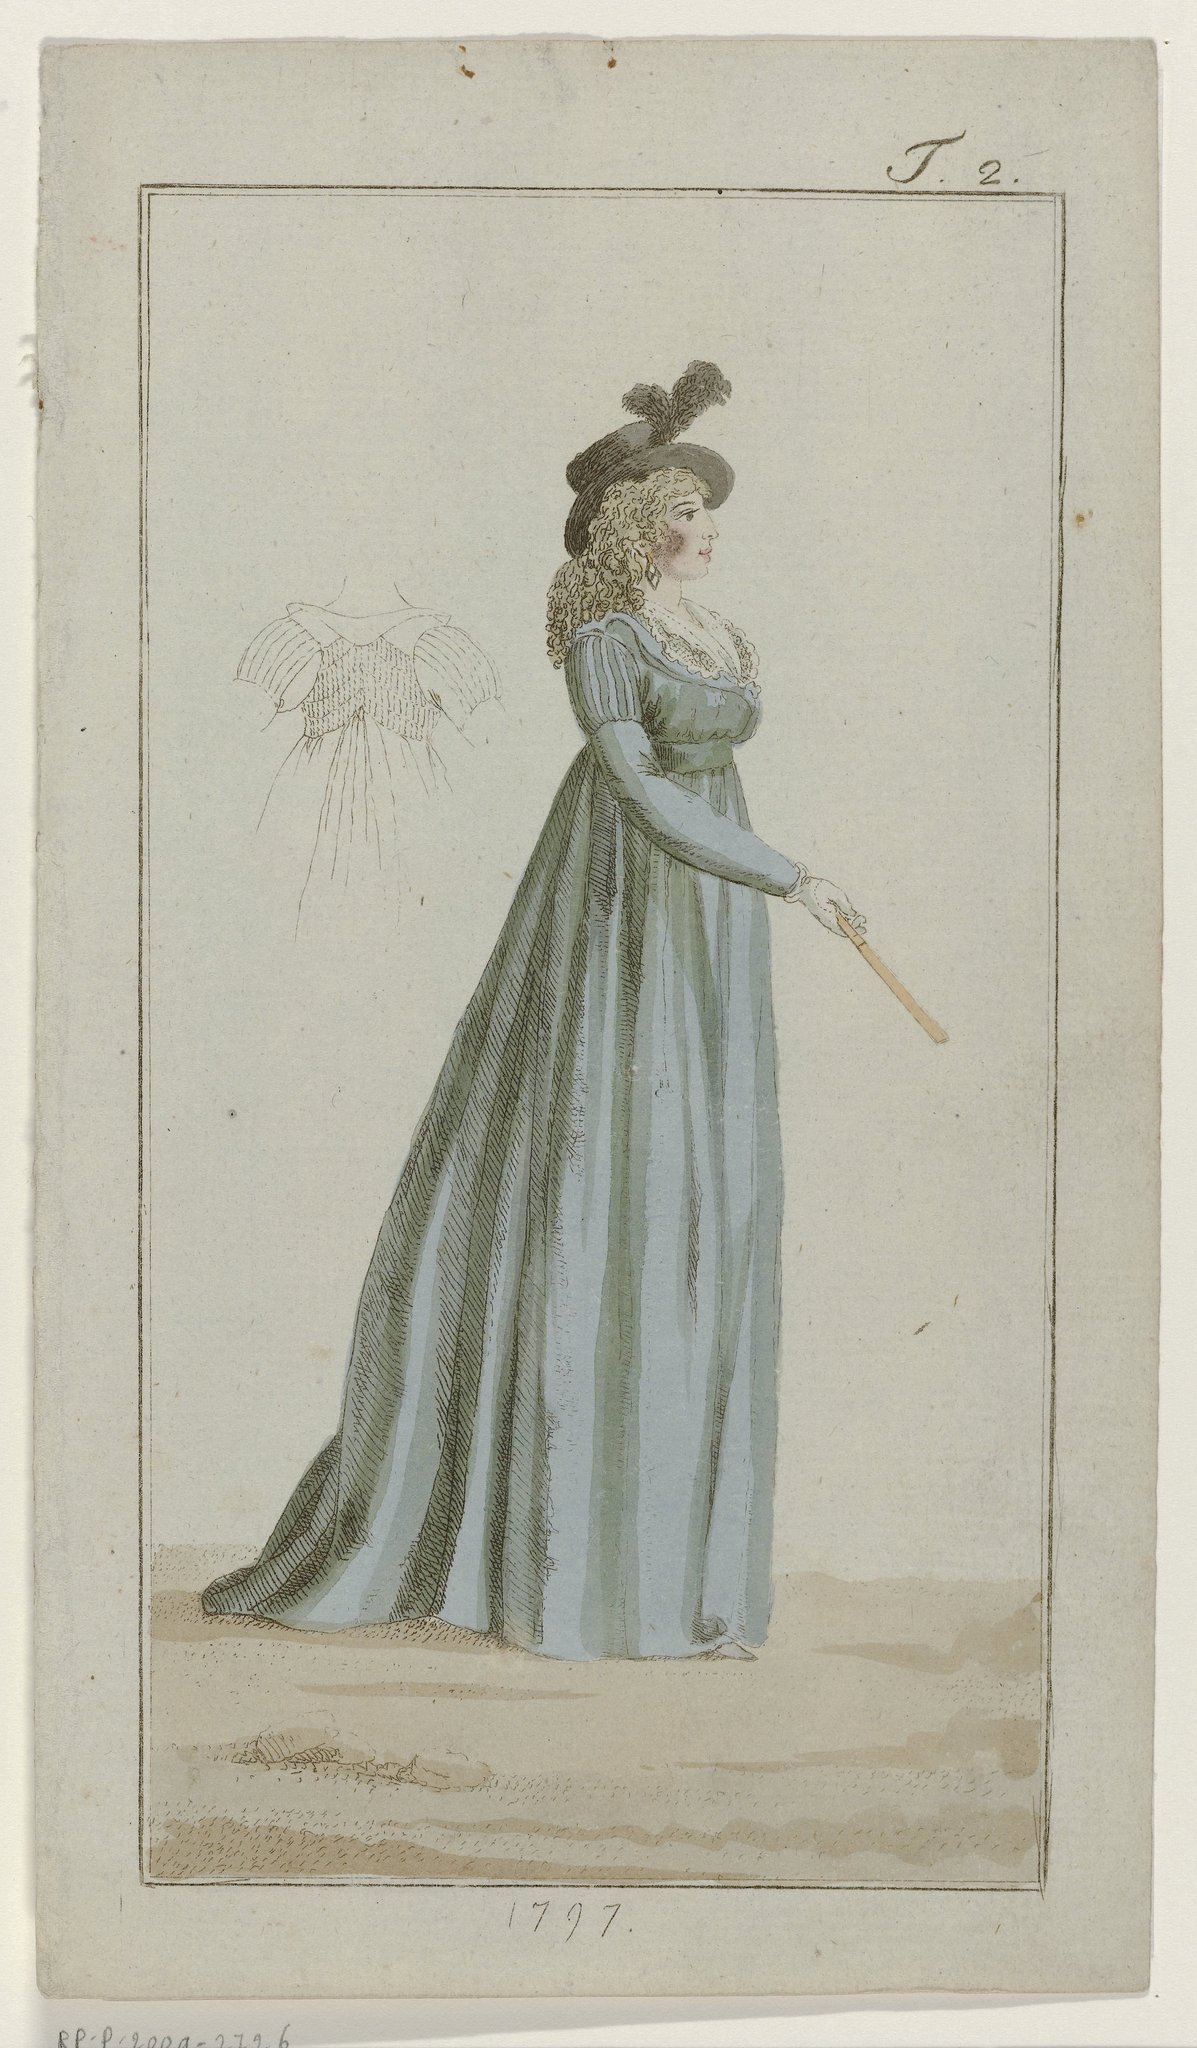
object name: fashion print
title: Journal des Luxus und der Moden, 1797, T 2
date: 1797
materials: paper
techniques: etching, hand coloring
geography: weimar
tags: ear-rings (+ women's clothes), head-gear (+ women's clothes), fashion plates, shoes, sandals (+ women's clothes), gloves, mittens, etc. (+ women's clothes), dress, gown (+ women's clothes), fan (+ women's clothes), piece of clothing covering the breast or décolleté (fichu) (+ women's clothes)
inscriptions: date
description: Staande vrouw gekleed in een japon met lange mouwen, hoge taille en sleepje. Accessoires: hoed met veren, oorbel in het rechteroor, fichu, handschoen, waaier. Links een detail van de achterzijde van de japon. Prent uit het modetijdschrift Journal des Luxus und der Moden, uitgegeven door Friedrich Justin Bertuch en Georg Melchior Kraus, Weimar, 1786-1826.